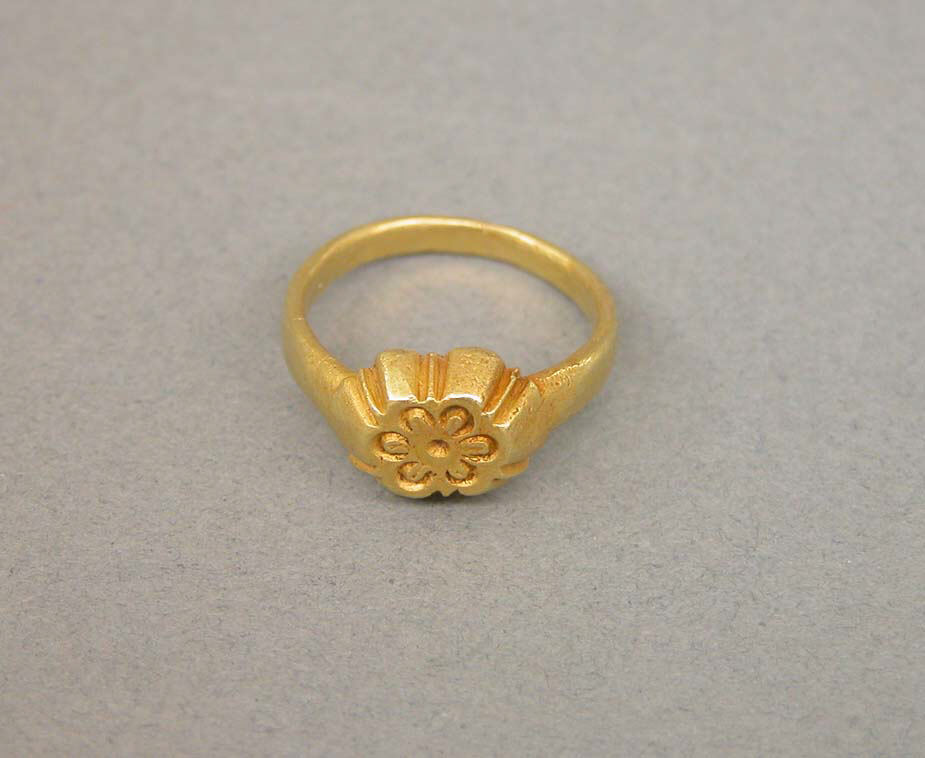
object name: ring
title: Ring with Floral-Shaped Bezel and Design Details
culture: indonesian, javanese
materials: gold